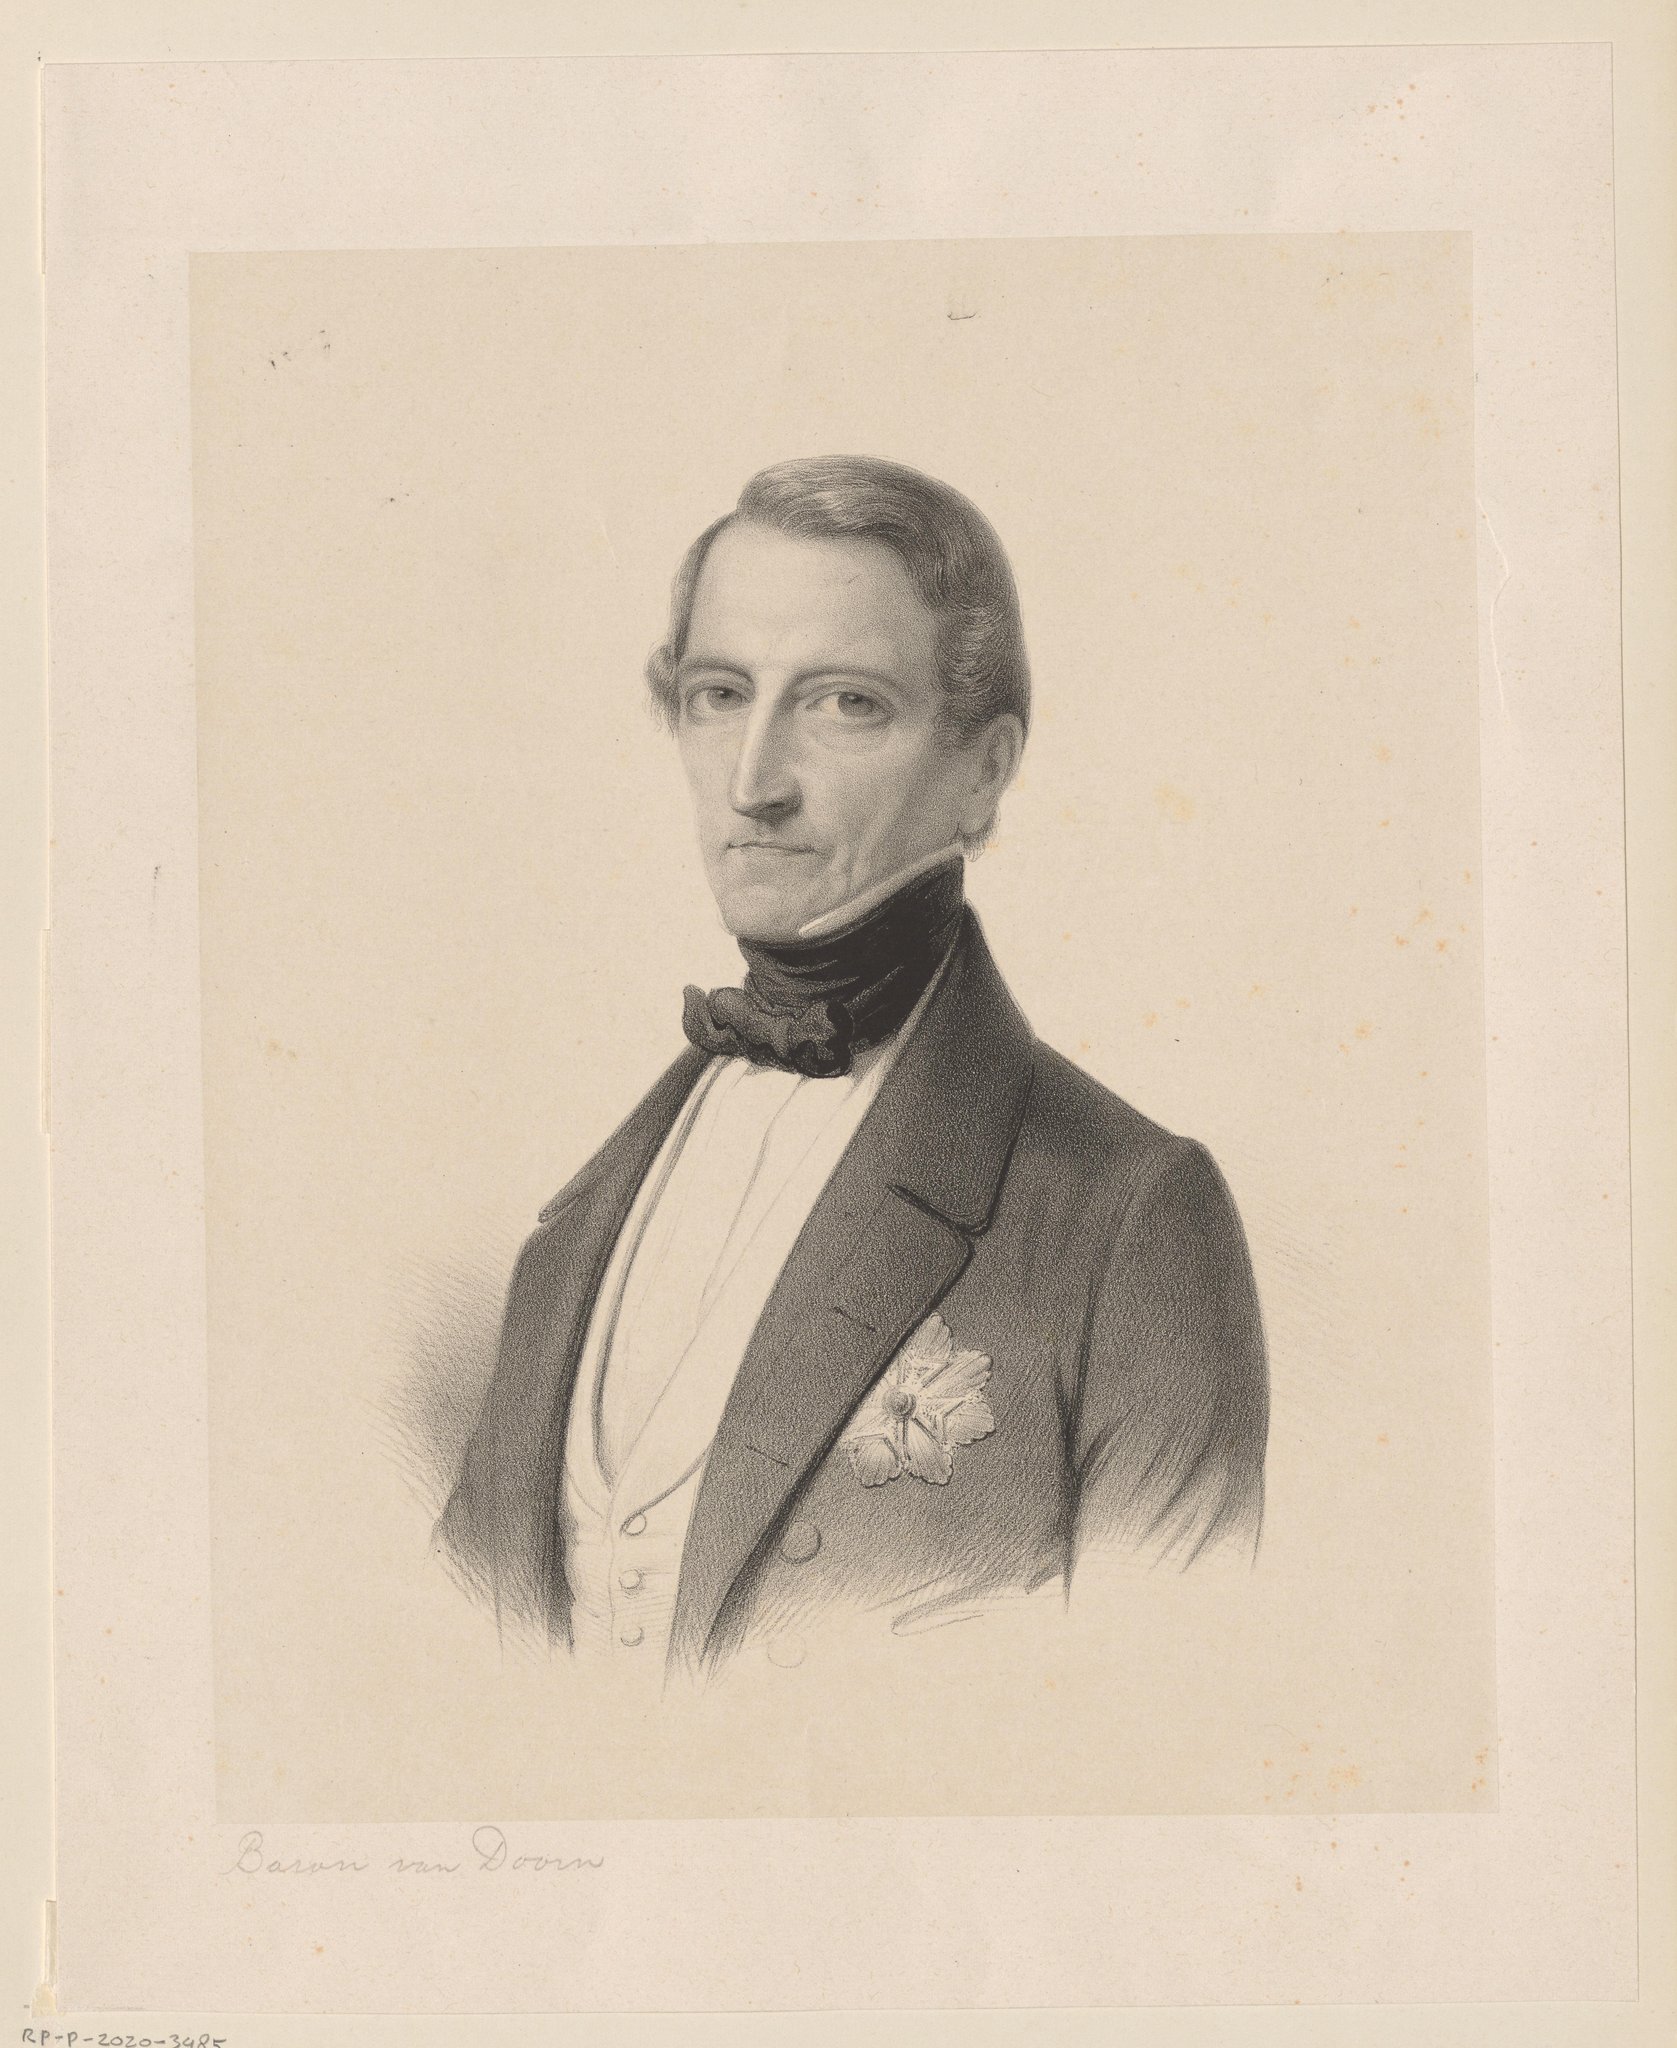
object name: print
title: Portret van Hendrik Jacob baron van Doorn van Westcapelle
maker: Anonymous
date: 1820-1860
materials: paper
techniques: lithograph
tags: the hague, politician, hendrik jacob baron van doorn van westcapelle, historical persons, politician, e.g. party leader